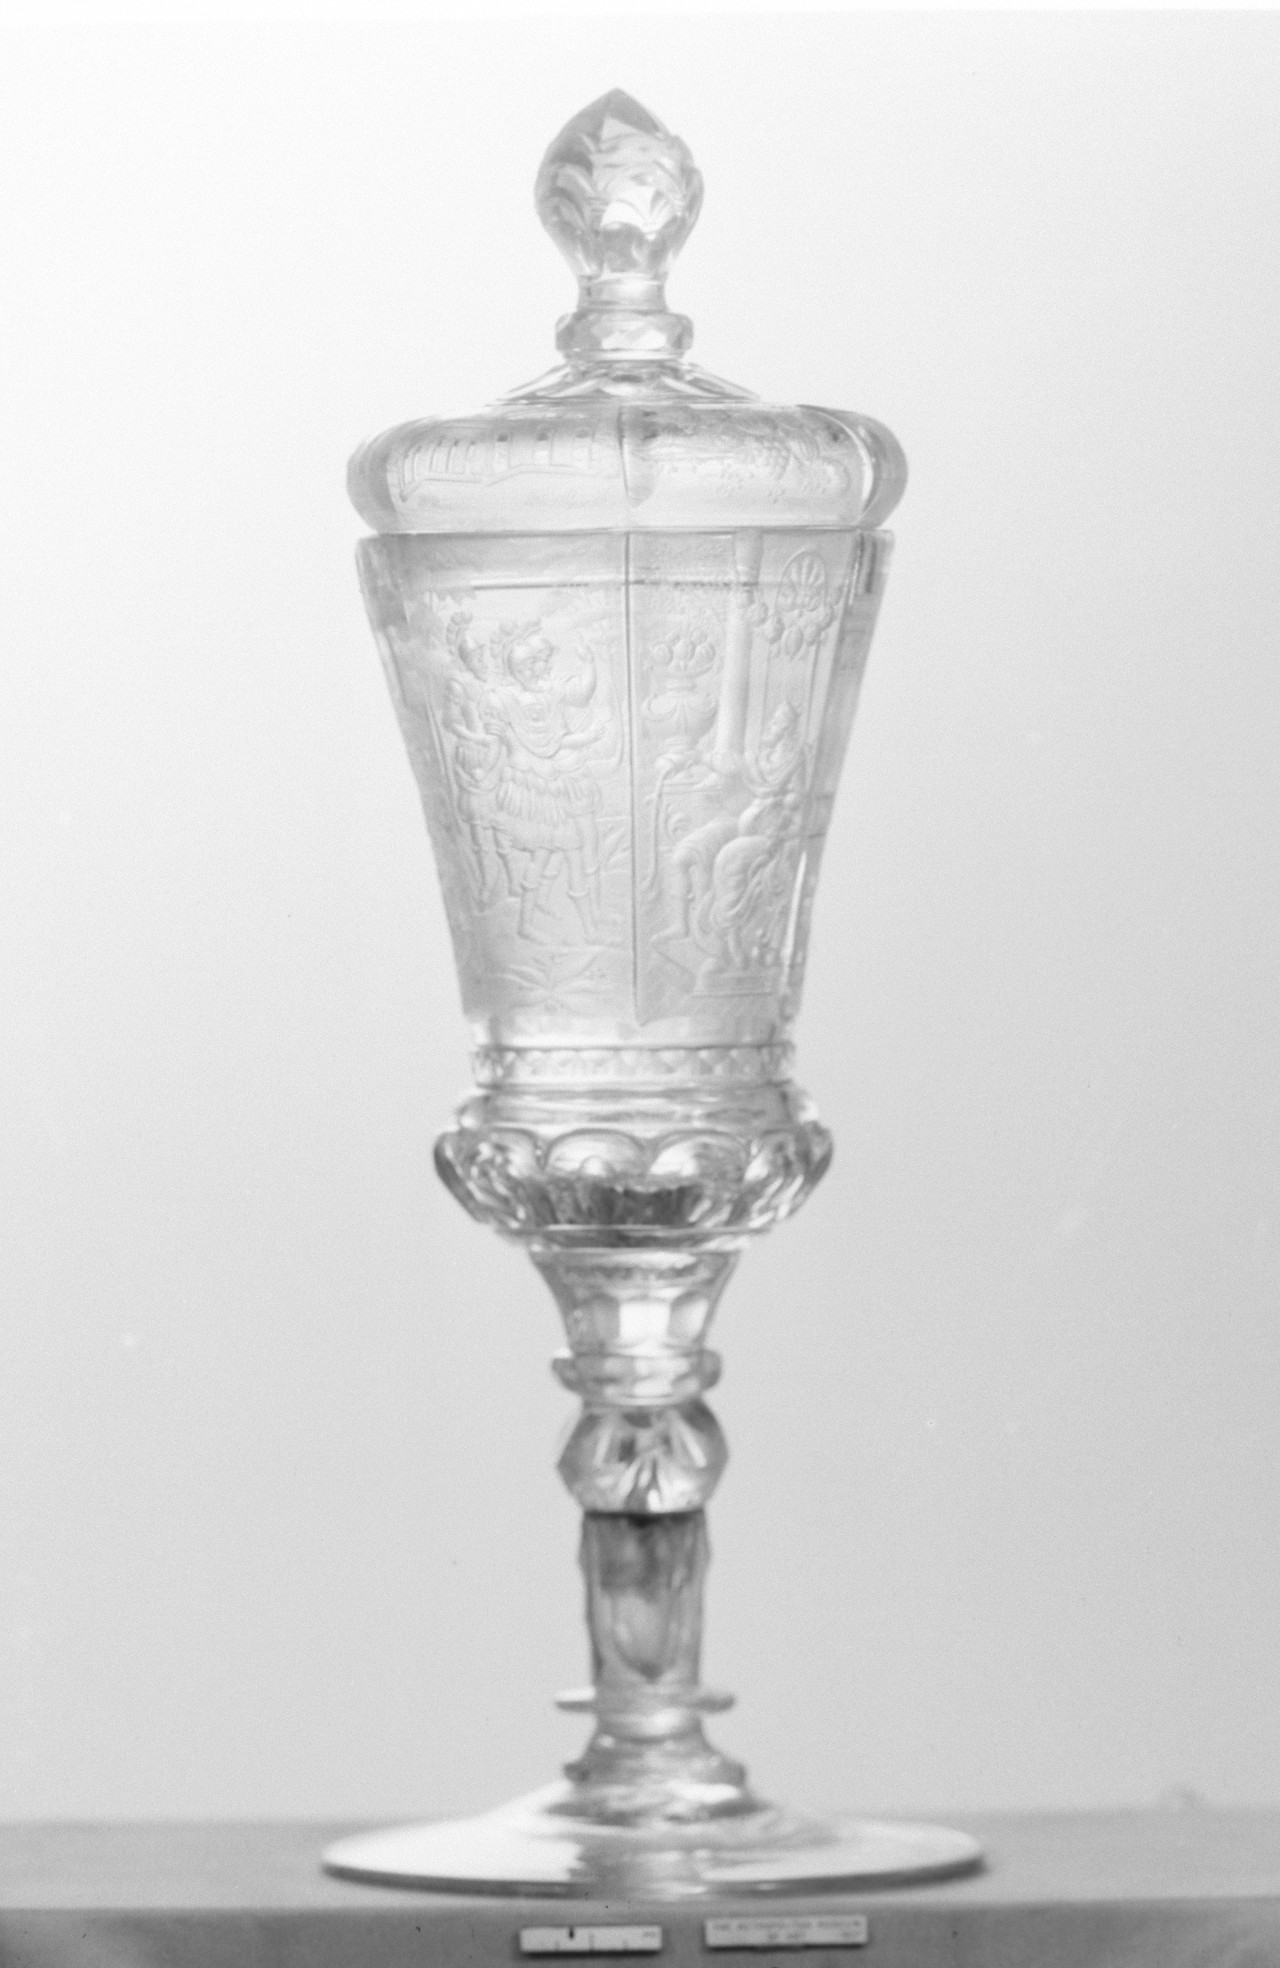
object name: standing cup with cover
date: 1701-1733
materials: glass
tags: soldiers,men